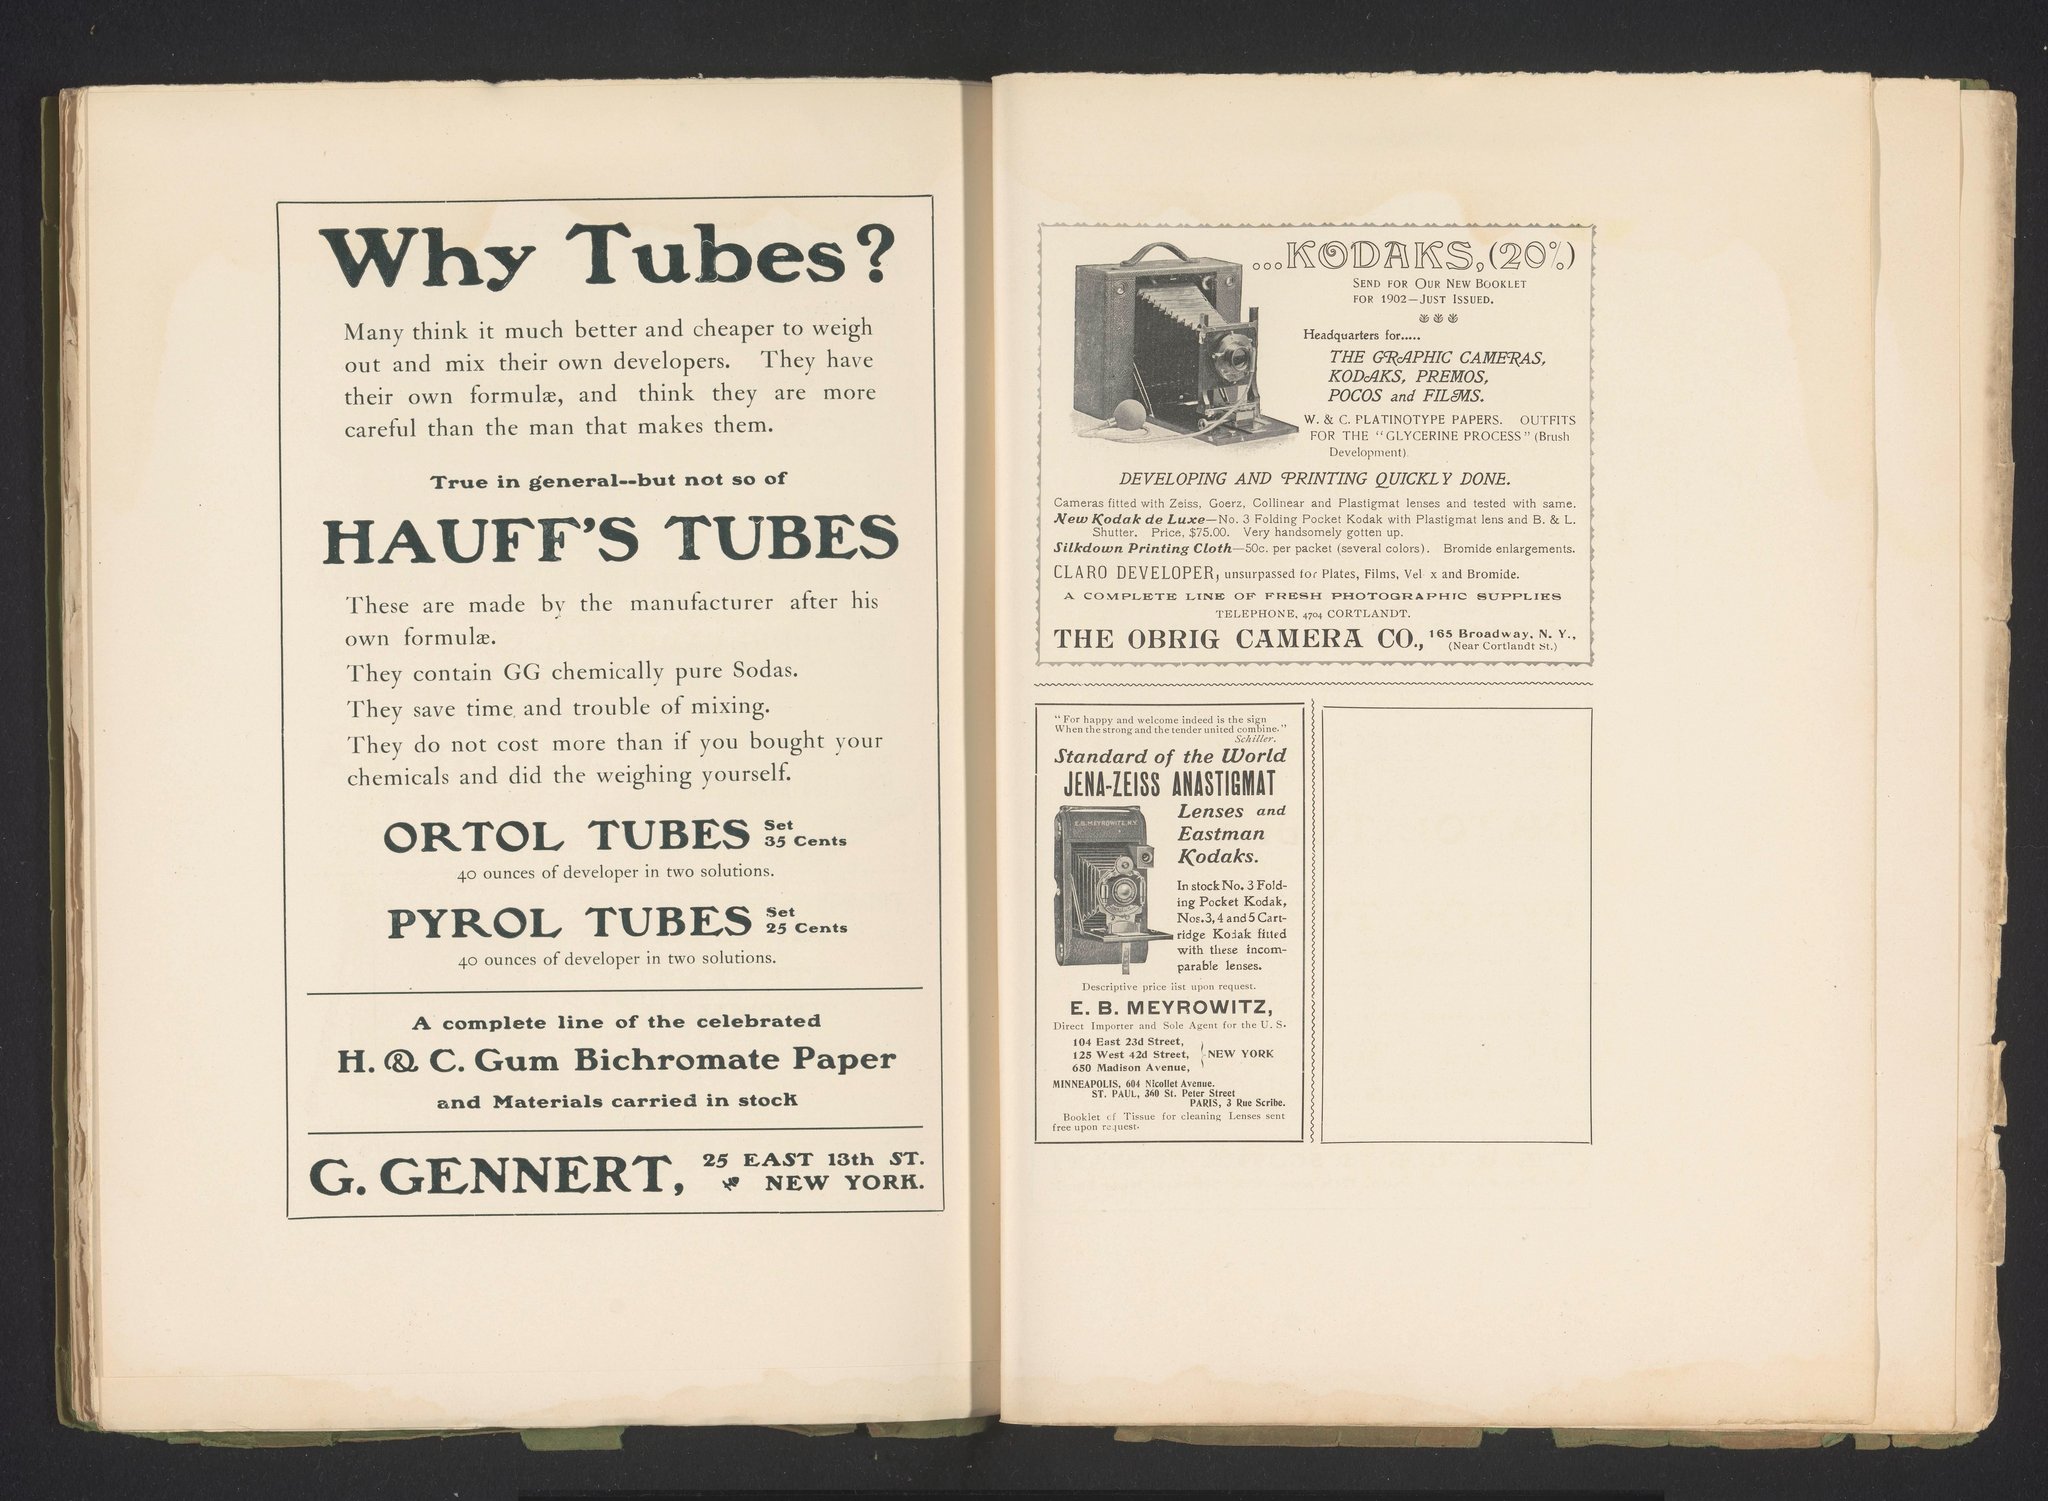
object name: photomechanical print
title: Kodak camera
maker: Anonymous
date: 1897-1902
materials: paper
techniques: autotype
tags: camera ~ photography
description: Prent in katern advertenties achterin boek. Prent is onderdeel van een reclameboodschap van Kodak.